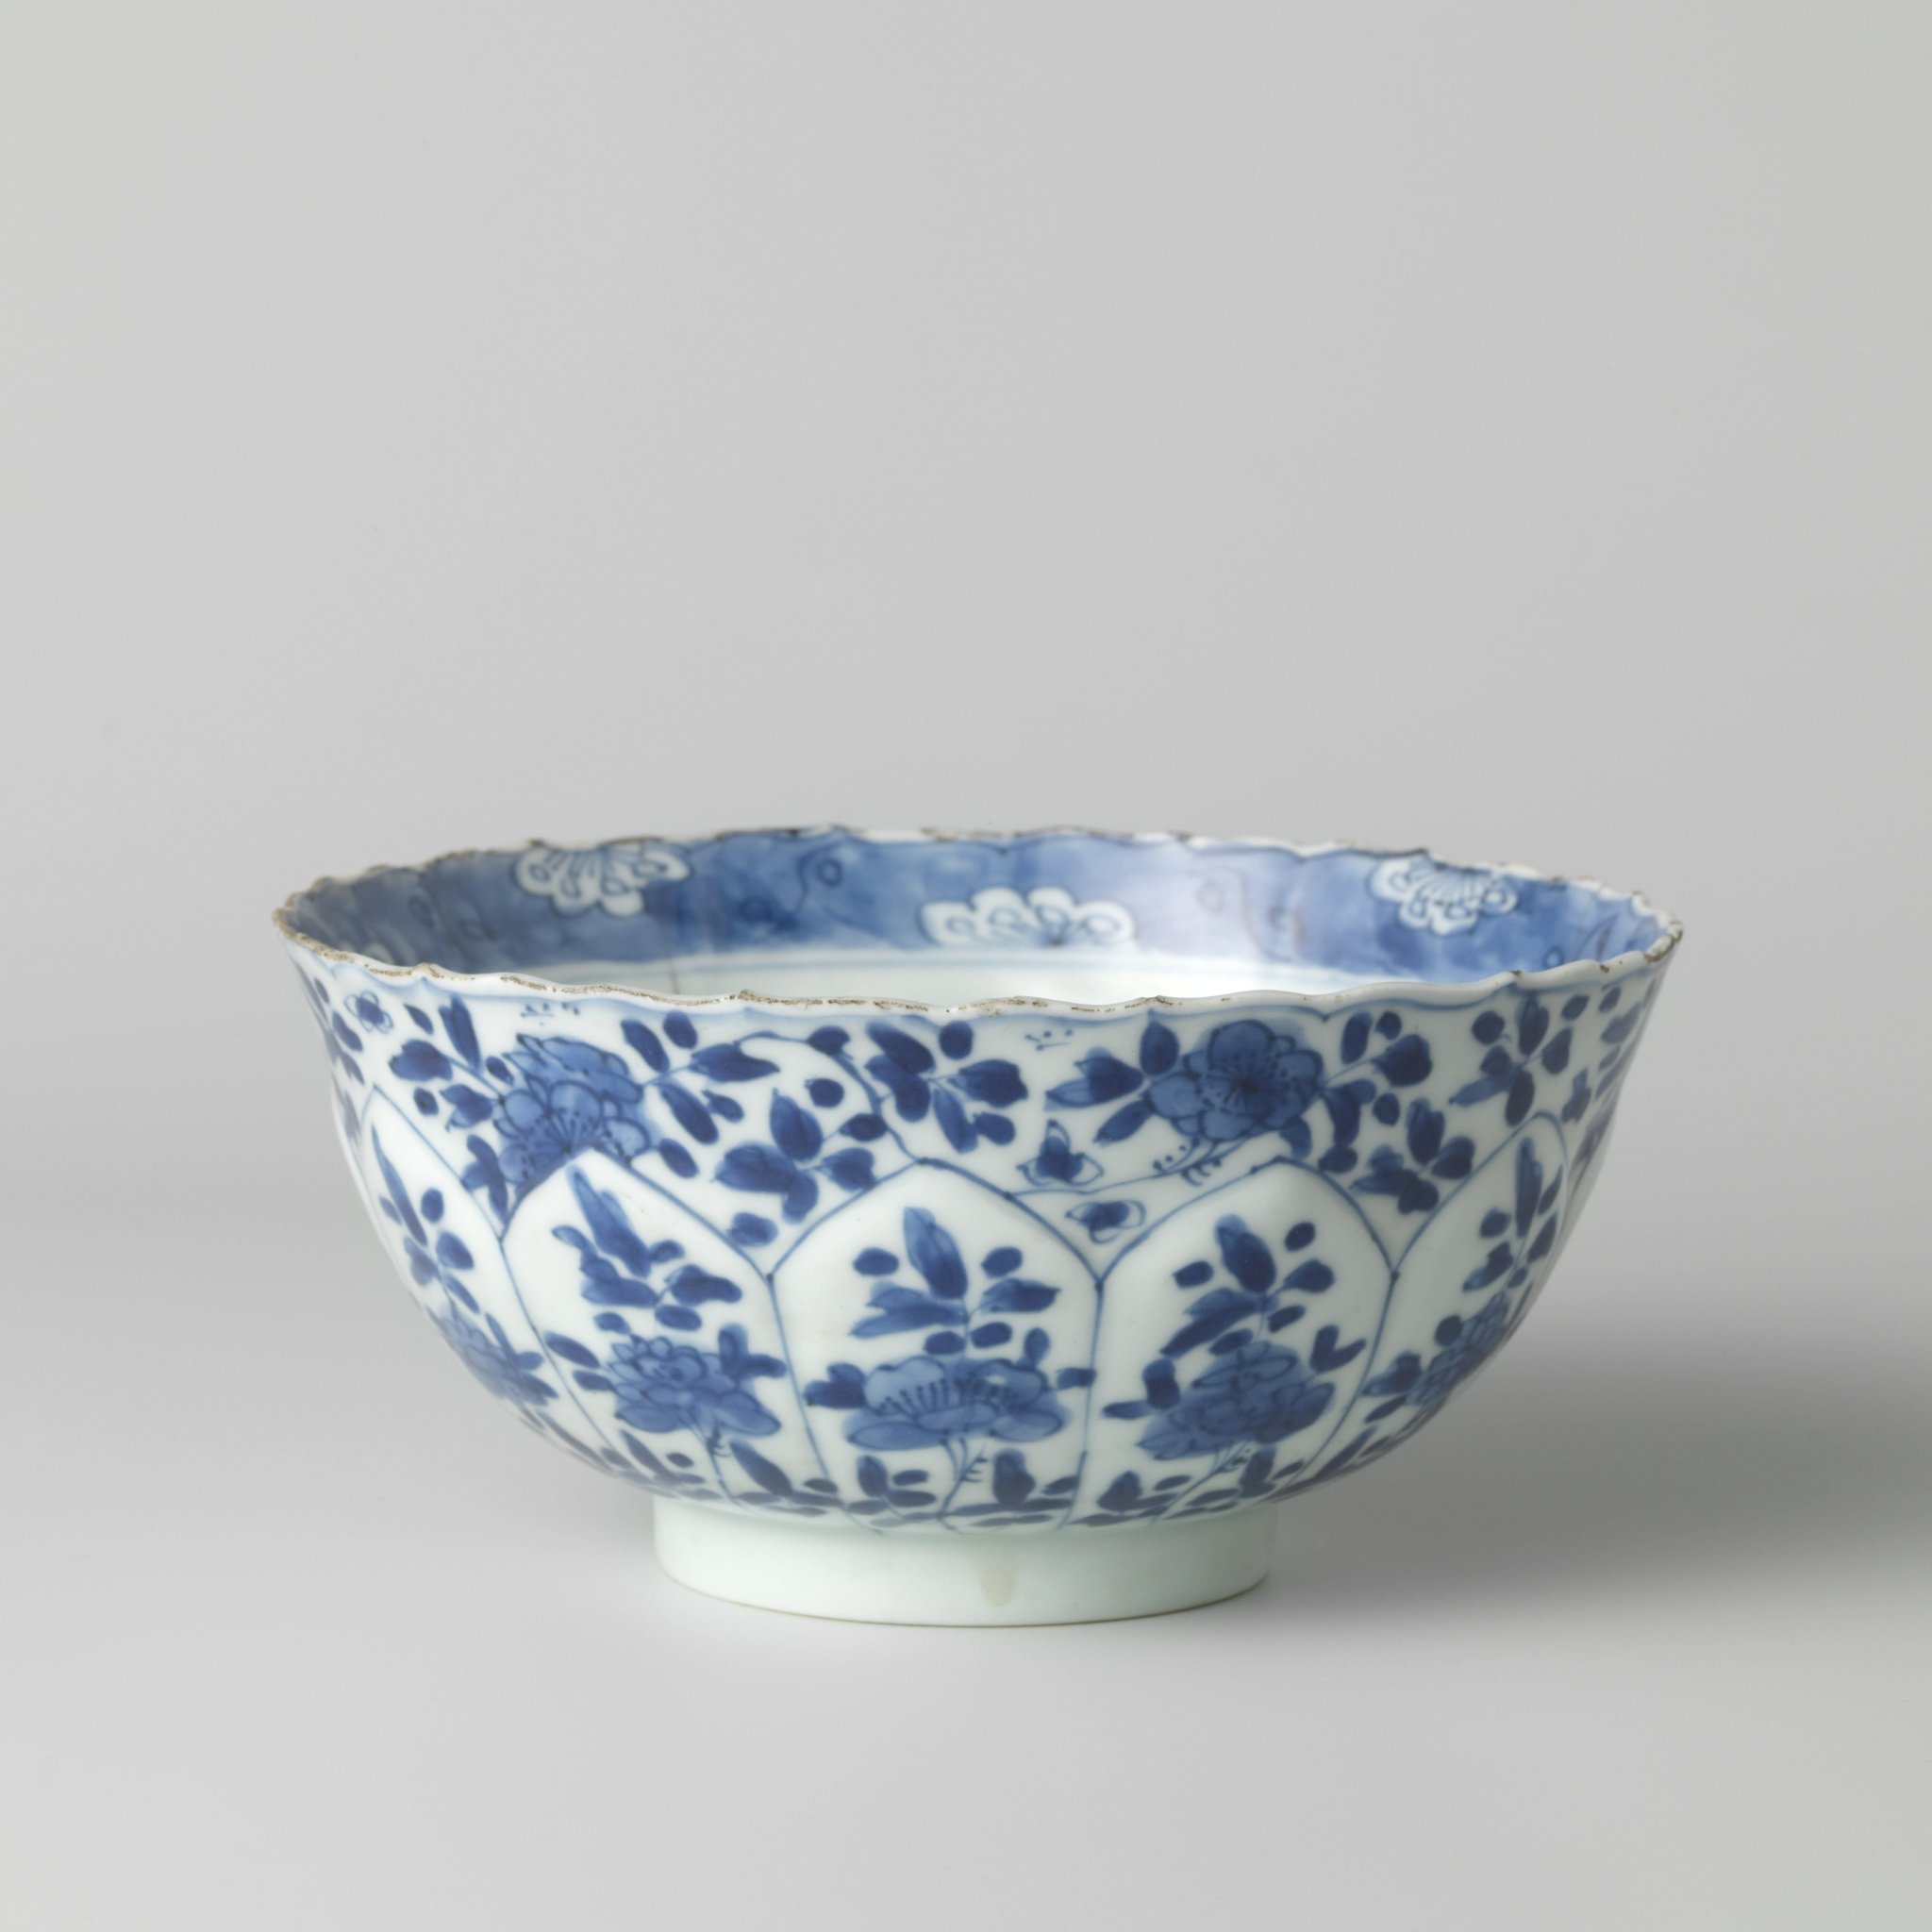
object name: bowl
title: Bell-shaped bowl with moulded panels and flower sprigs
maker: Anonymous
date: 1700-1724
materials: cobalt, glaze, paint, porcelain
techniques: firing, forming, turning, vitrification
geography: china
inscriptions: mark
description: Kom, met puntvormige vakken in relief gevuld met bloemtakjes.